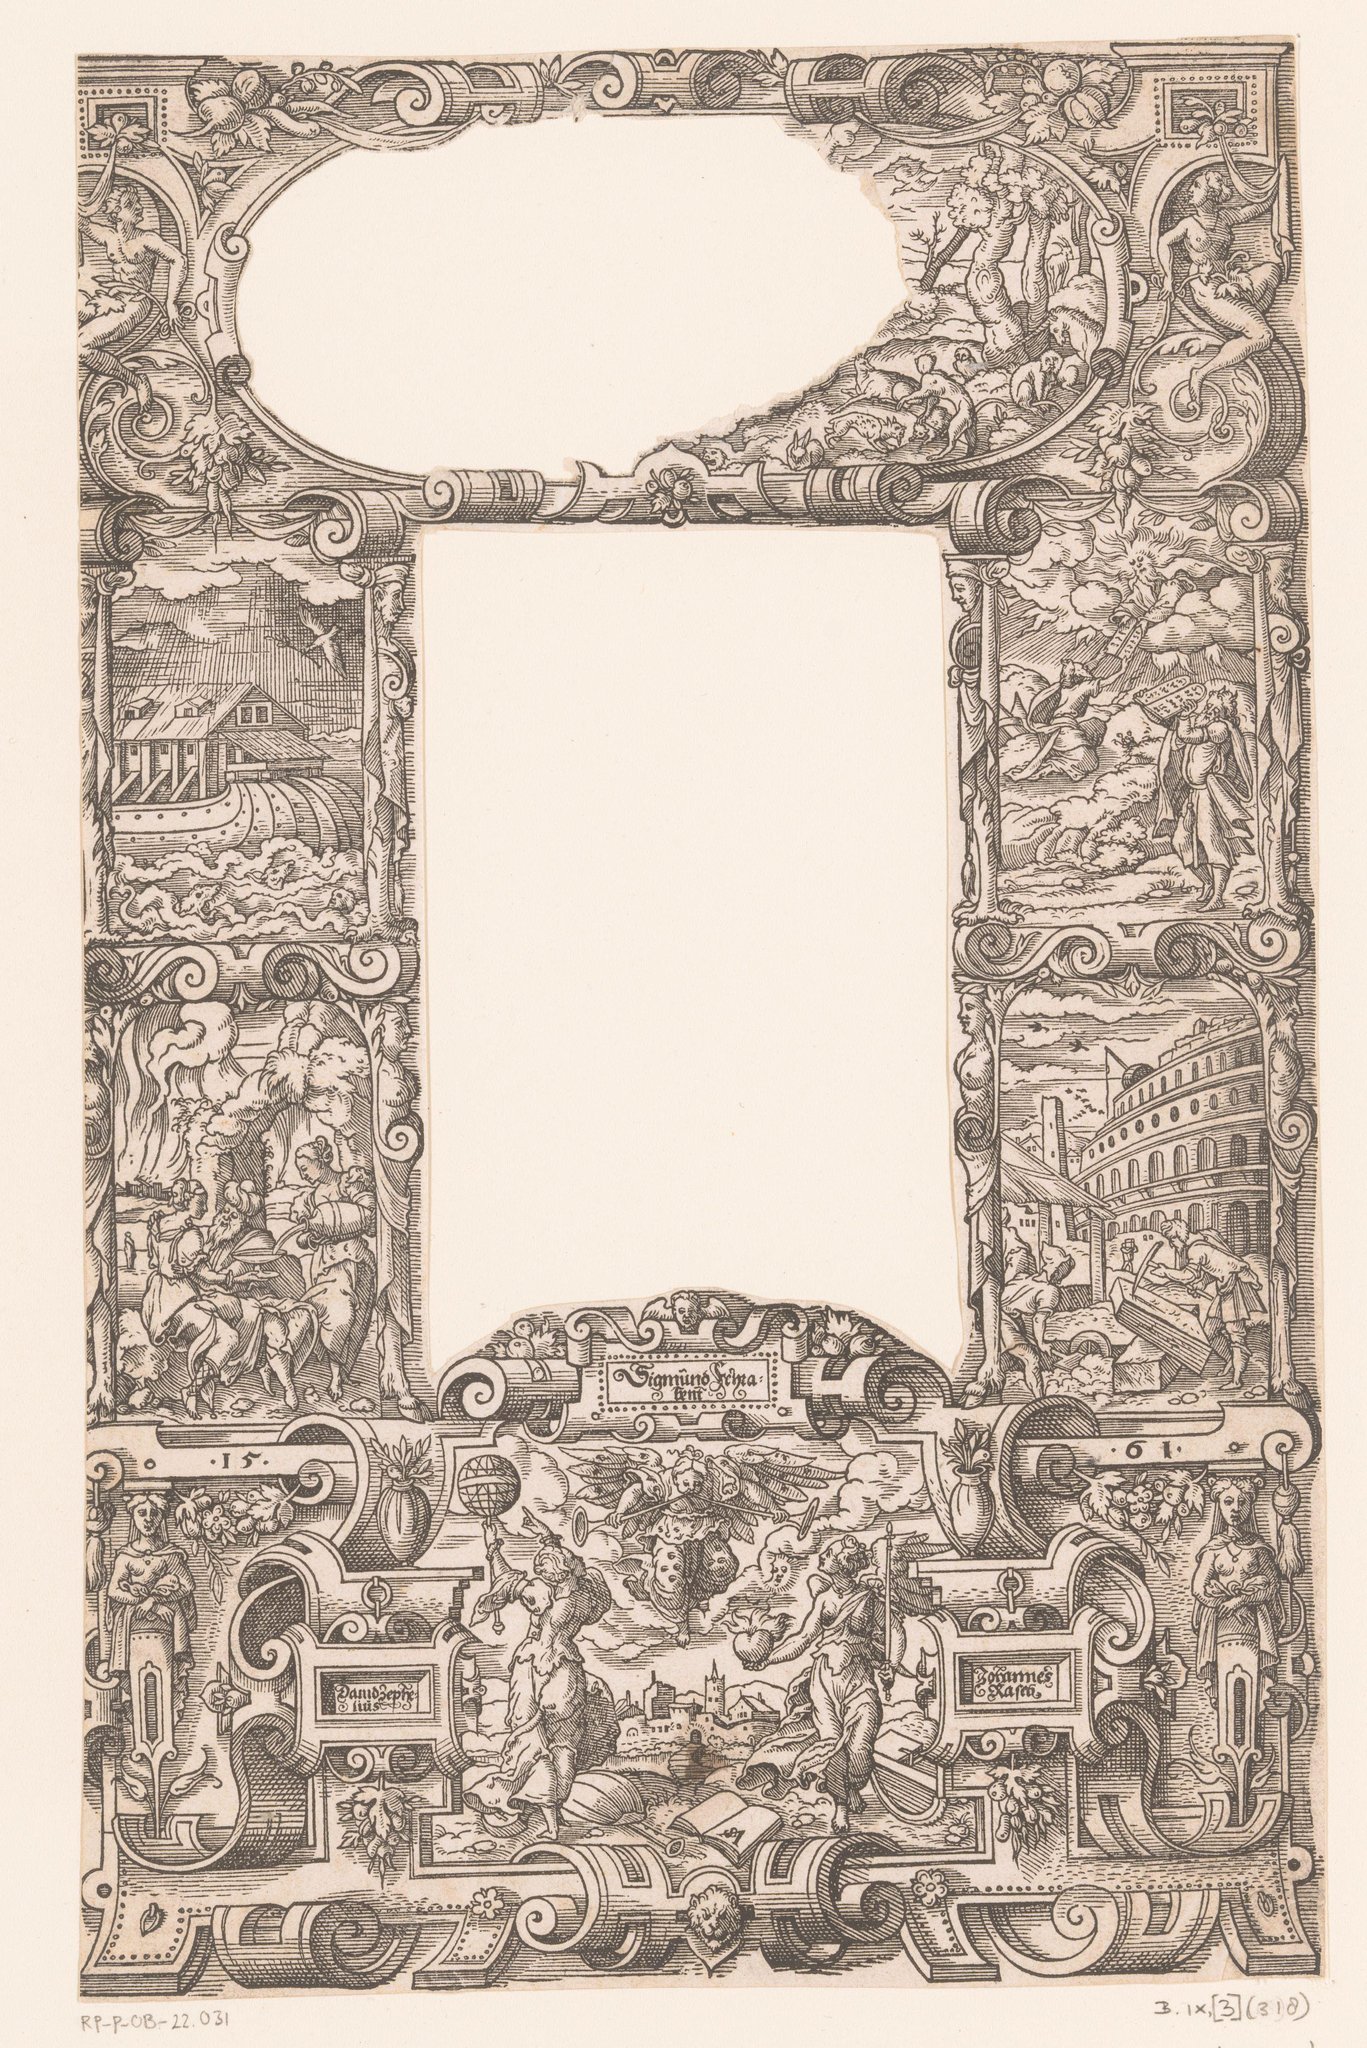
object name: print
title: Ornamentlijst met rolwerk en vijf oudtestamentische scènes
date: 1561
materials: paper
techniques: woodcut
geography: frankfurt am main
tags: the building of the tower of babel; nimrod may be present, supervising or assisting the construction, scrollwork, strapwork ~ ornament, moses receives the tables of the law from god, the ark is floating on the waters, while life on earth is destroyed ~ story of noah, the six days of creation (genesis 1:3-25), lot's daughters make their father drunk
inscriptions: number: ‘173’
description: Prent gebruikt als titelpagina voor de publicatie: Luther, Martin. Biblia Das ist Die gantze Heylige Schrifft. Frankfurt am Main: Johann Rasch en Sigmund Feyerabend en David Zephelius, 1561. Twee gedeelten van de prent zijn uitgesneden.